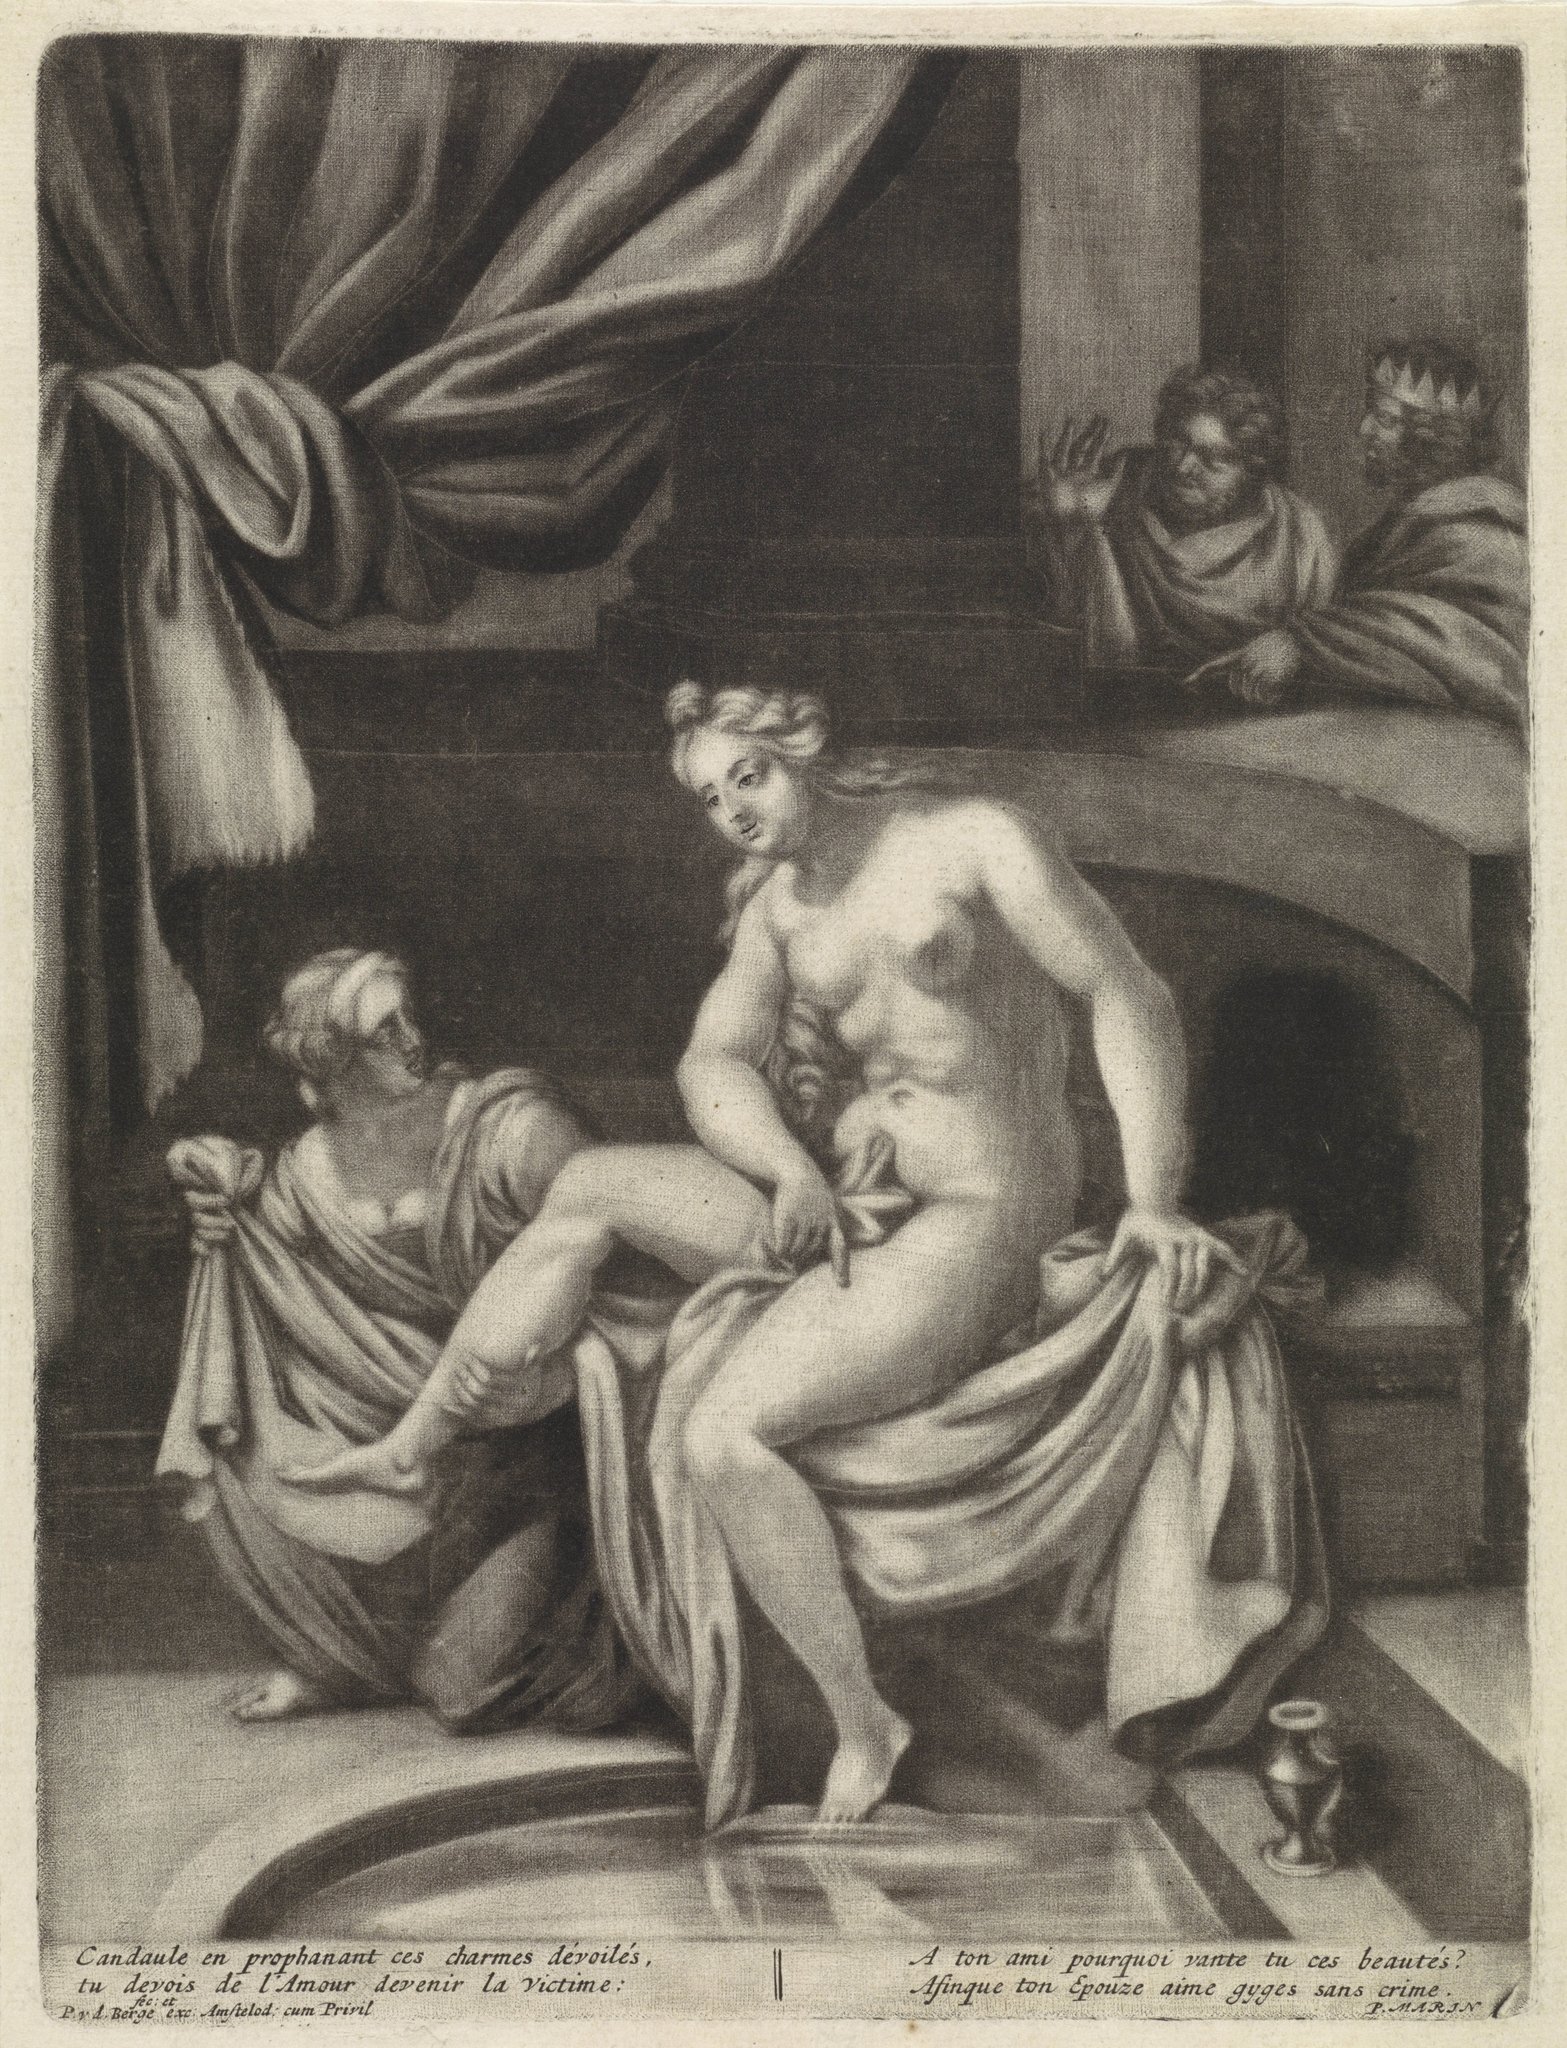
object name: print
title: David en Batseba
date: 1692-1737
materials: paper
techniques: engraving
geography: amsterdam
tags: david, from the roof (or balcony) of his palace, sees bathsheba bathing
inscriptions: collector's mark: Lugt 2228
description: Batseba wast haar voeten in een bron terwijl Koning David haar vanaf zijn dakterras bespiedt (2 Samuel 11:2). Hij stuurt een bode met de opdracht Batseba naar het paleis te halen.